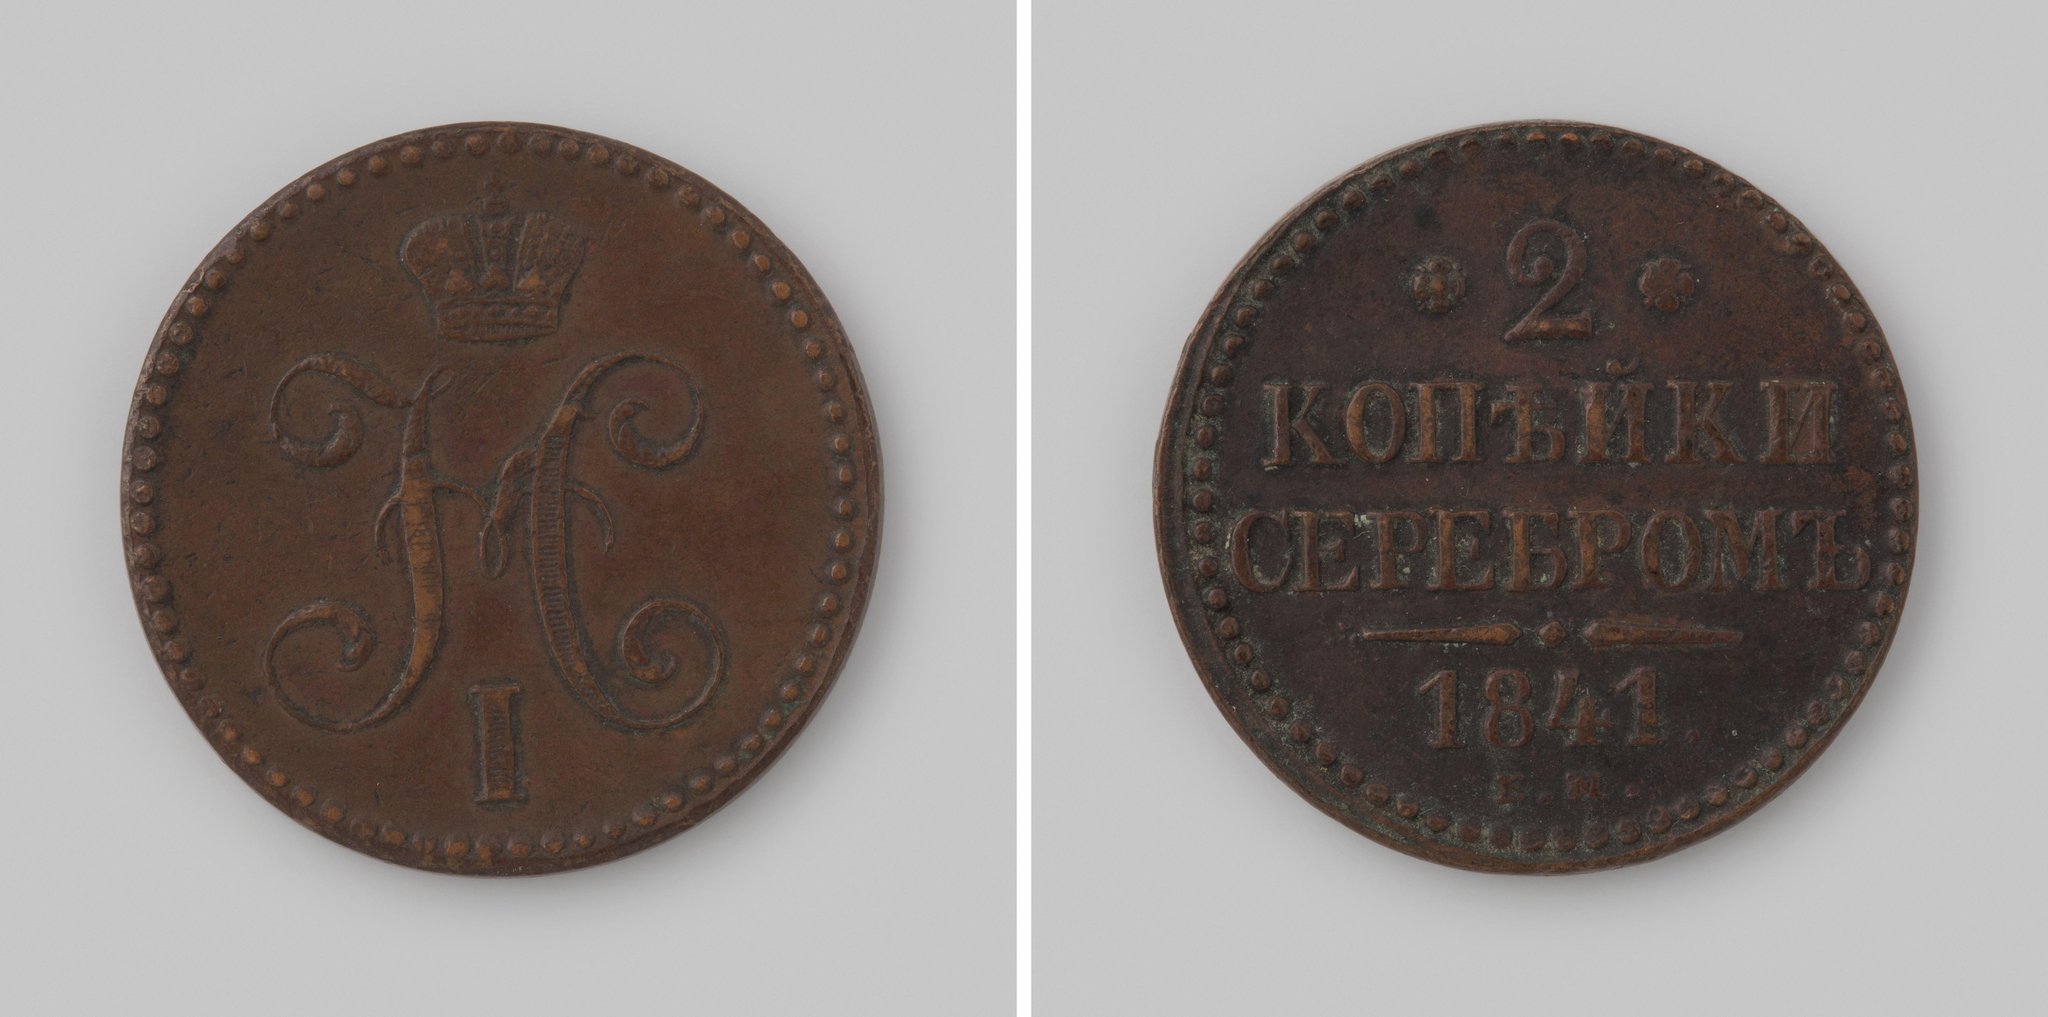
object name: coin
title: Rusland, tsaar Nikolai I, 2 kopeken, 1841 EM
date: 1841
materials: copper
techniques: striking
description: Koperen munt. Voorzijde: gekroond monogram van Nicolai I in het cyrillisch. Keerzijde: in drie regels waarde-aanduiding. Daaronder jaartal, waaronder in het Cyrillisch de letters E en M [=Ekaterinenburg]. Gladde rand.